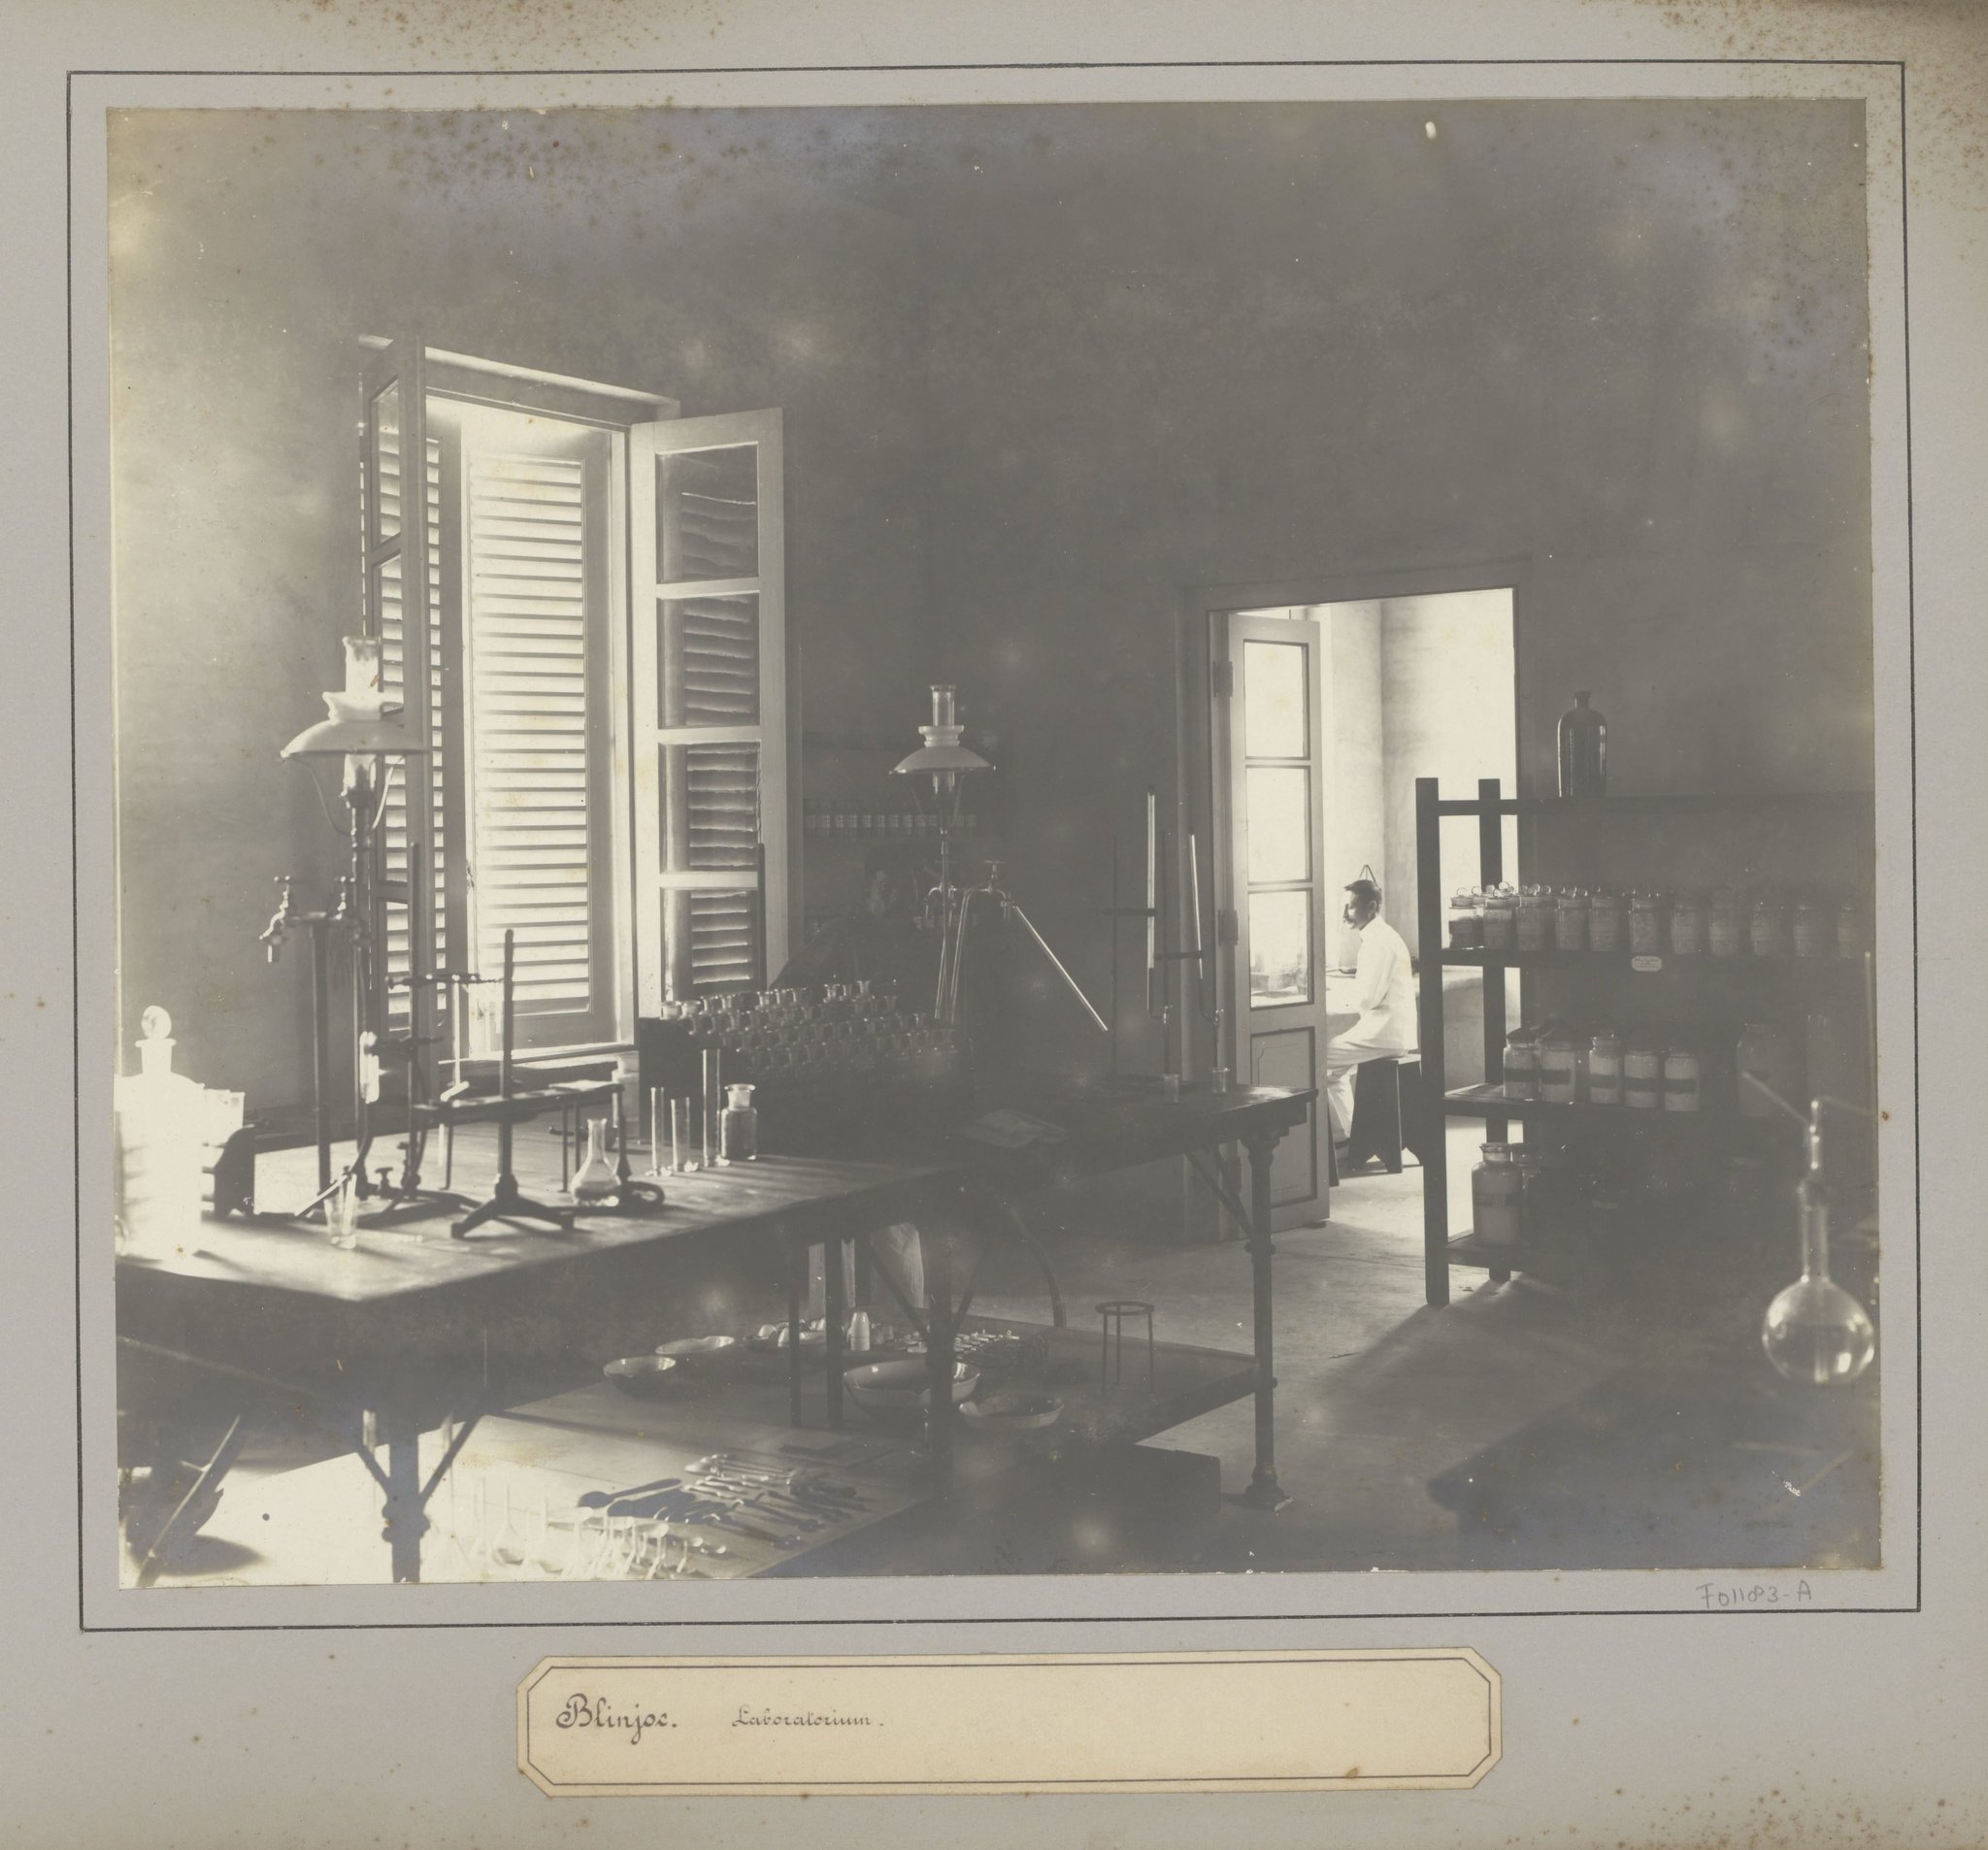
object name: photograph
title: Blinjoe. Laboratorium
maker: Anonymous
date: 1900-1920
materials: photographic support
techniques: gelatin silver print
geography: belinyu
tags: mining, minerals and metals: tin, laboratory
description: Onderdeel van Fotoalbum over de tinwinning op Bangka.